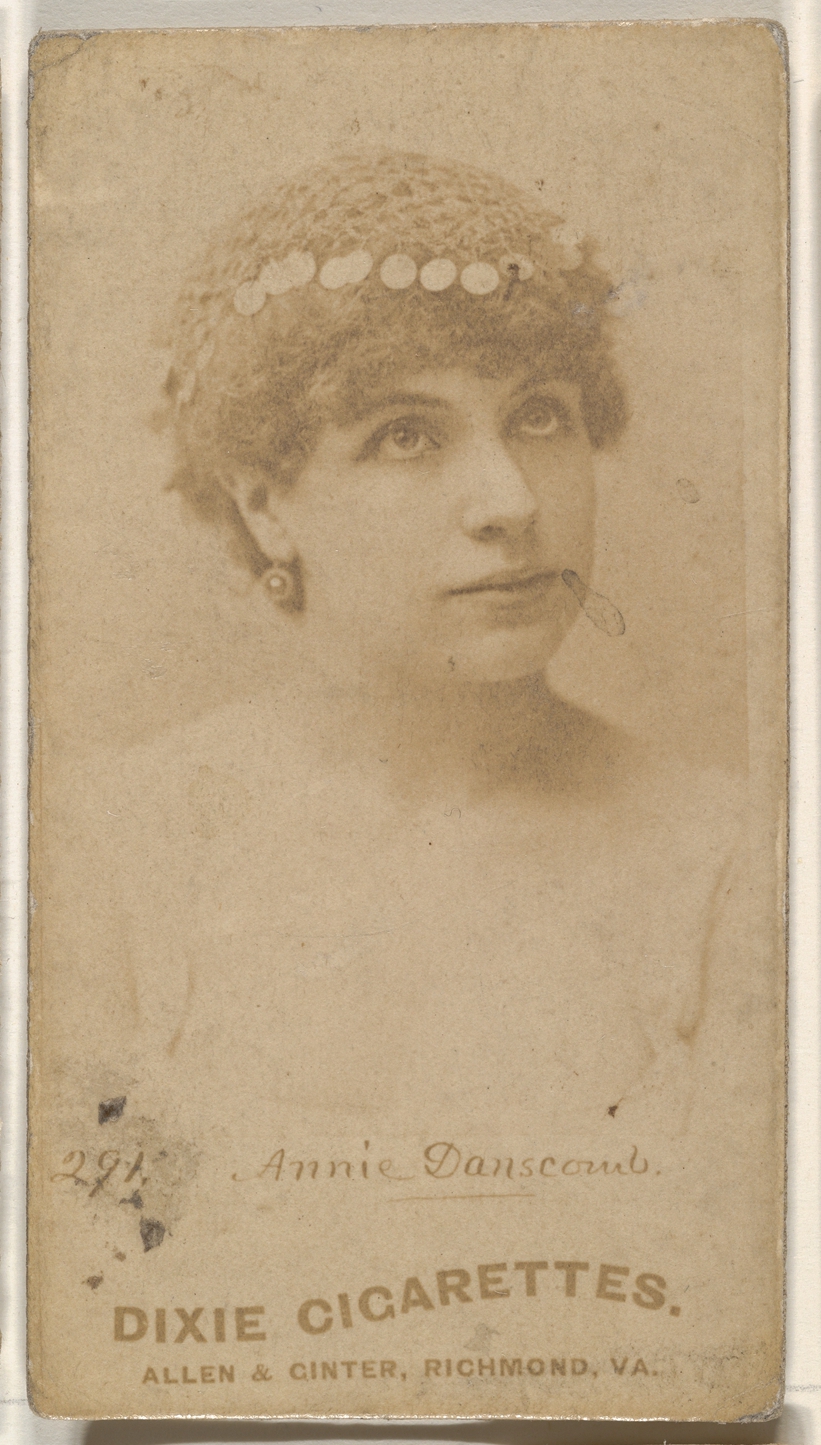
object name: photograph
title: Card 291, Annie Danscomb, from the Actors and Actresses series (N45, Type 1) for Virginia Brights Cigarettes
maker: allen & ginter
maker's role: publisher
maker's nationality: american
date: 1888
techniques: albumen silver print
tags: portraits,women,actresses